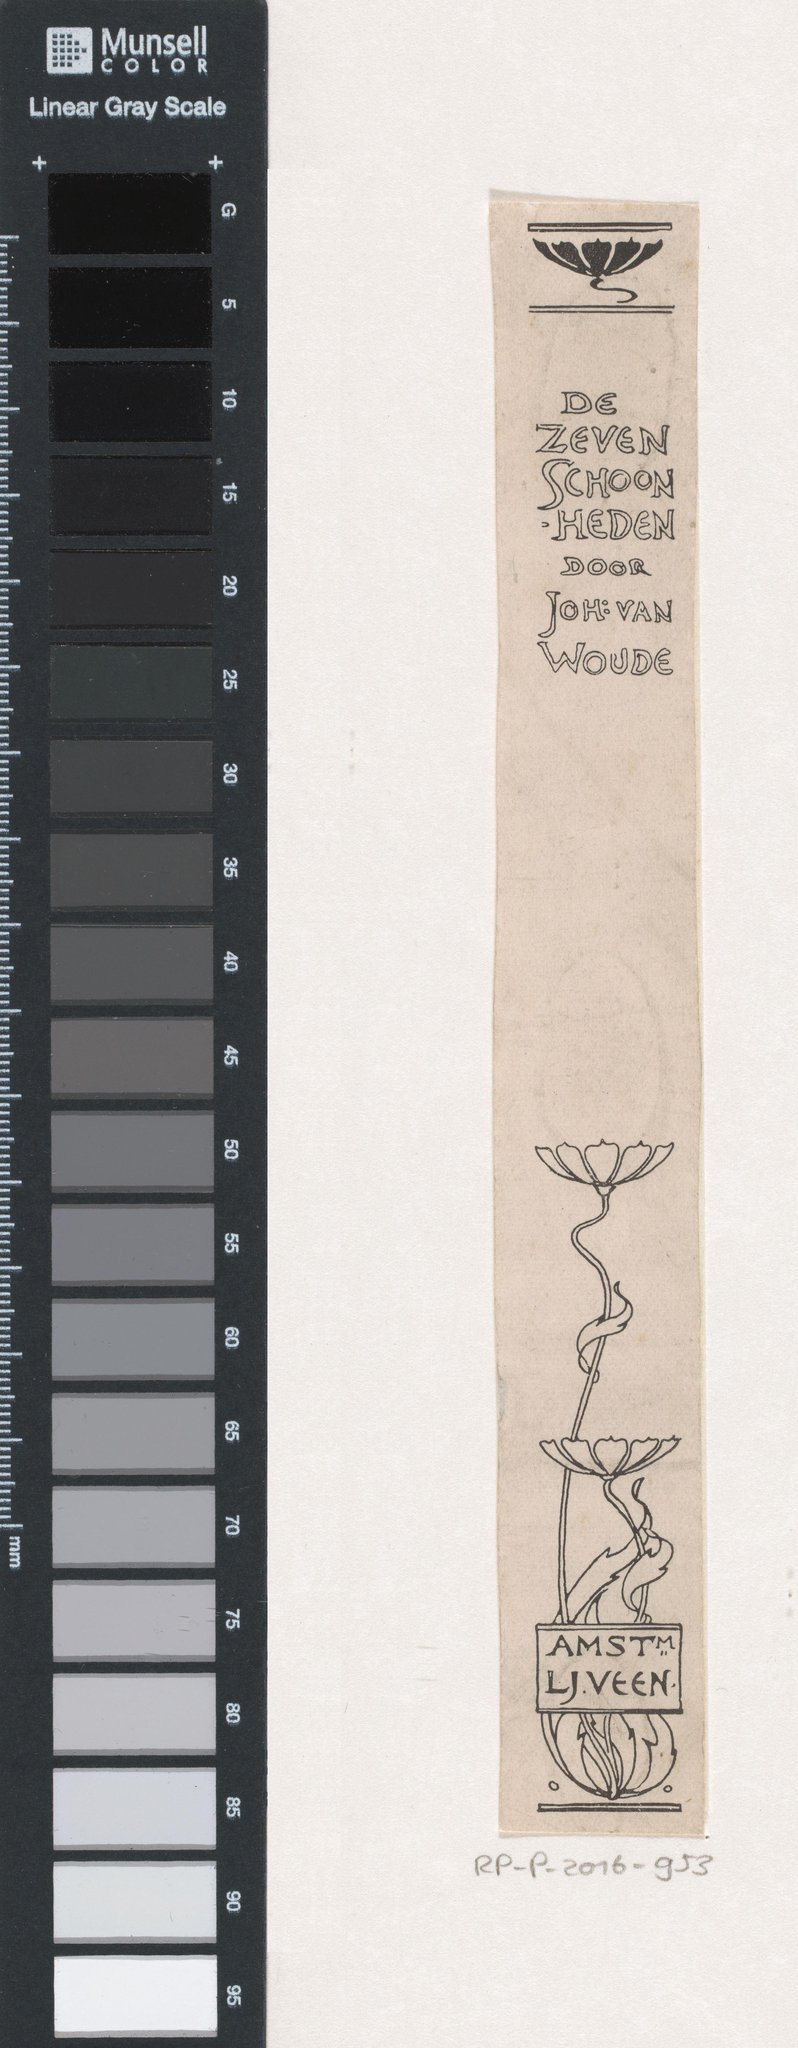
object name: boekrug ontwerp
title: Ontwerp voor een boekrug voor: Johanna van Woude, De zeven schoonheden, 1897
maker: Anonymous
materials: paper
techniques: printing block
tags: flowers ~ ornament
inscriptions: collector's mark: Lugt 2228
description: Boven de boektitel en auteursnaam een gestileerde bloemkelk. Onderaan de uitgeversnaam in een kader met daarachter twee opwaarts groeiende bloemen.